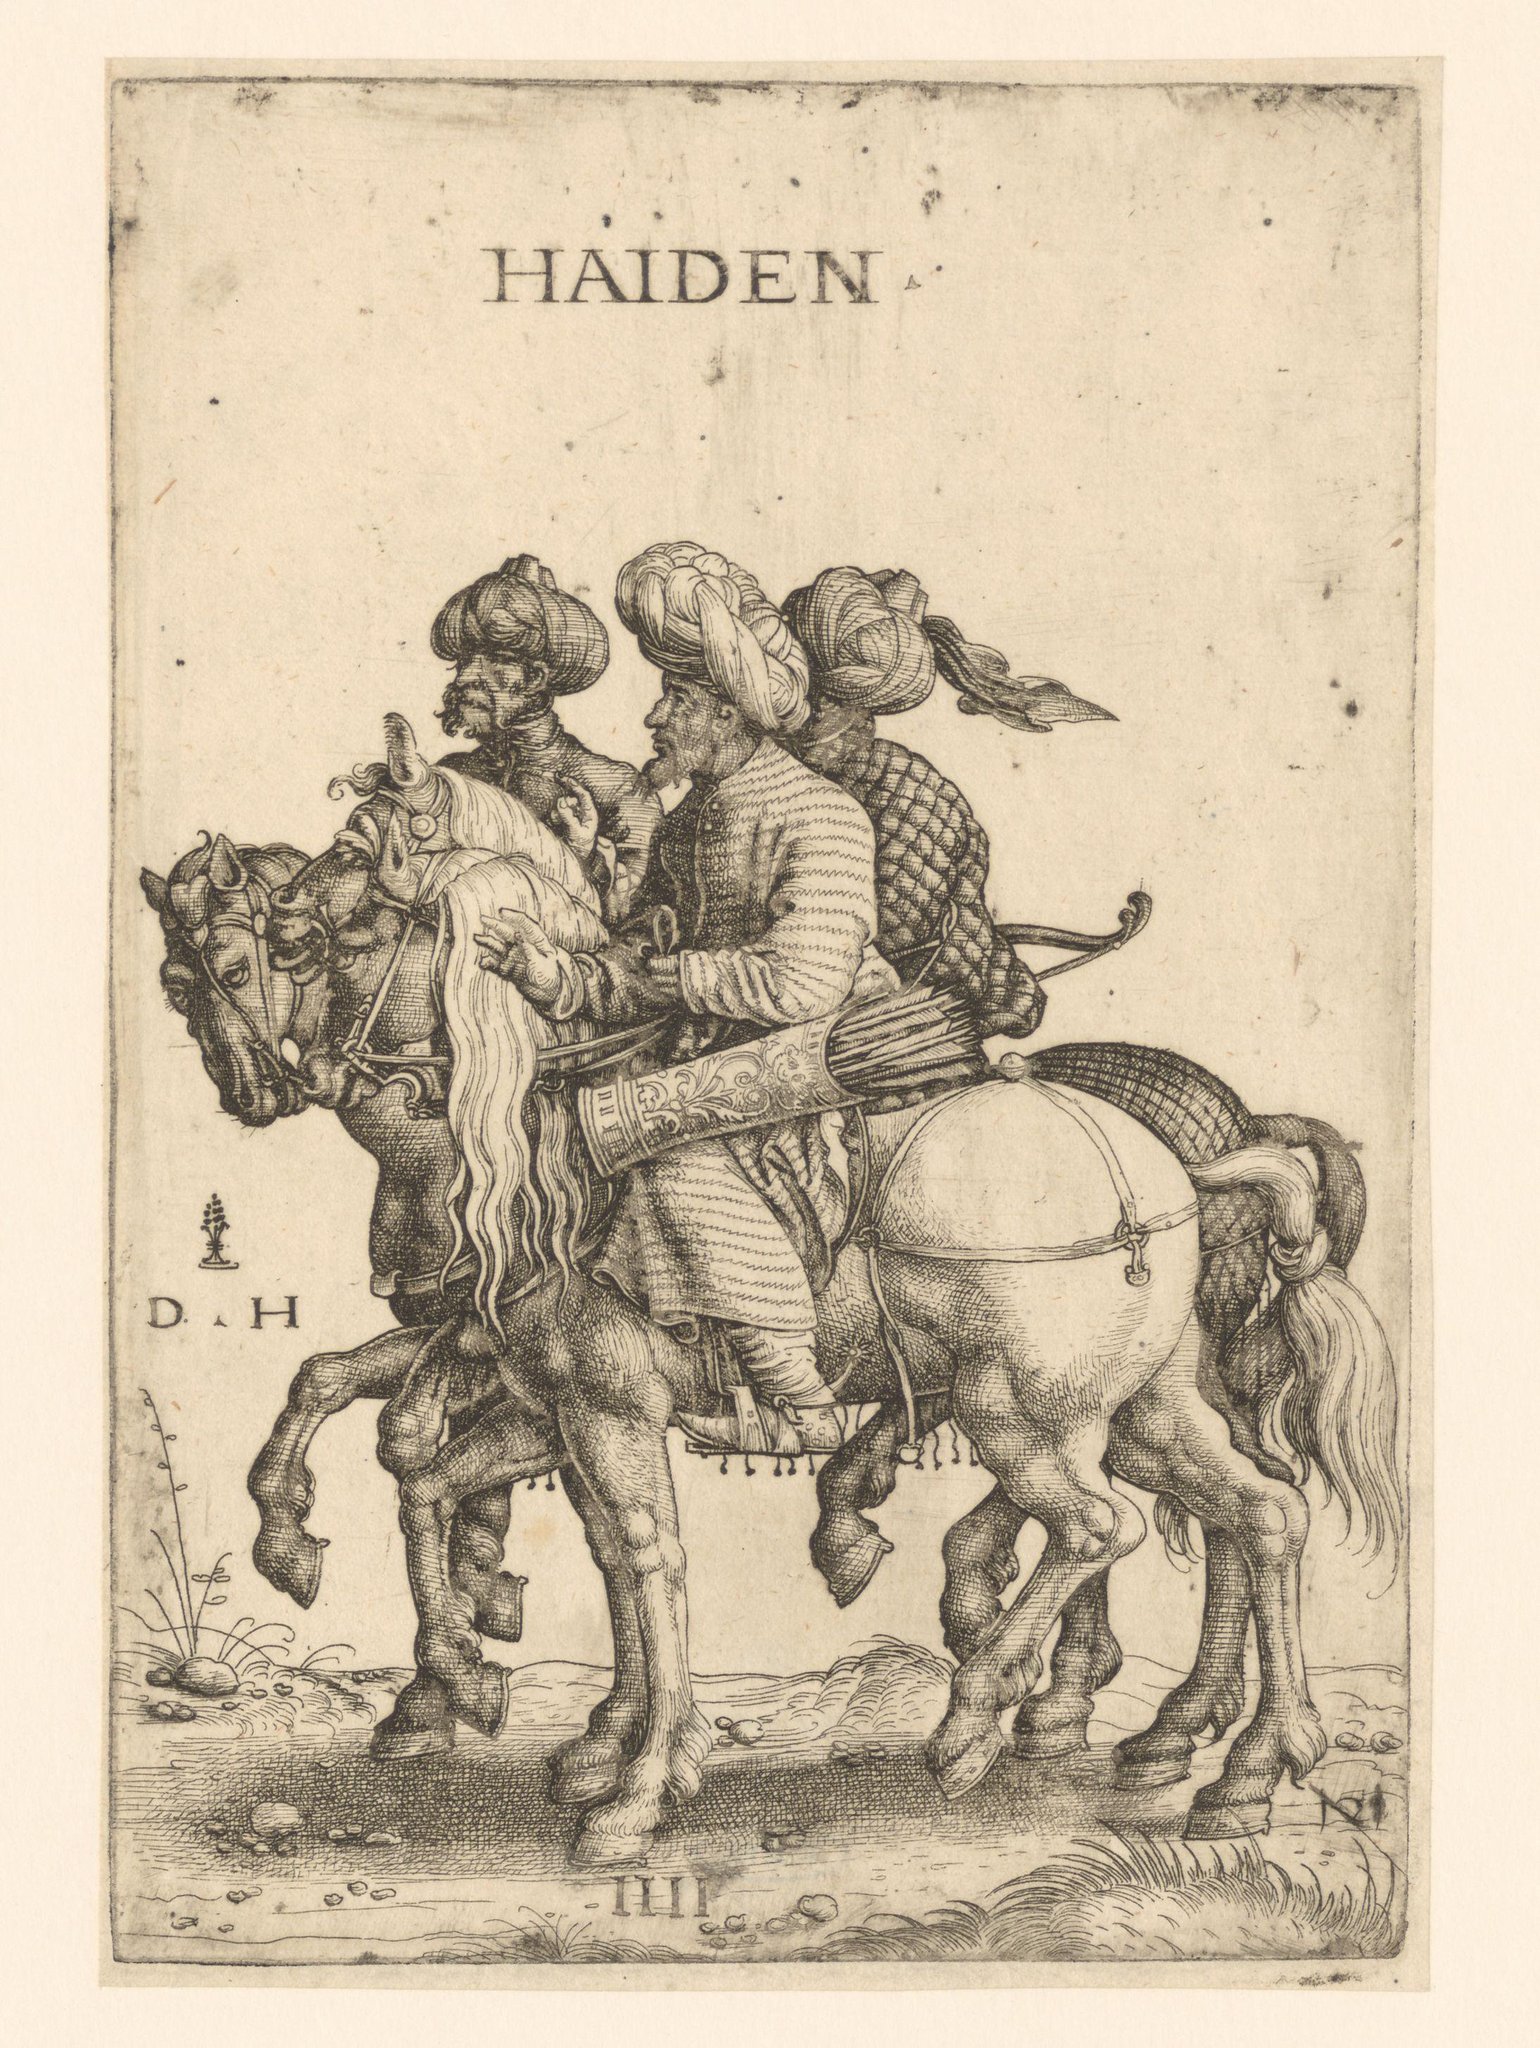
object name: print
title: Haiden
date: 1530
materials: paper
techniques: etching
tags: triumphal entry and public reception, pageant, 'entrée solennelle', 'joyeuse entrée', military parade, pageant, (military) uniforms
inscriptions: collector's mark: Lugt 2228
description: Deze prent is onderdeel van een serie naar Jan Swart's ontwerp uit 1526 met vijf prenten van Kanu Sultan Süleyman en zijn cortège, getiteld 'Soleiman de Grote en Turkse ruiters'. David Funck (1642-1709) kocht 230 ijzeren platen van de prentenmakers uit de familie Hopfer aan, nummerde deze (nu bekend als het Funck nummer) en herdrukte de verder onaangetaste platen onder de titel Operae Hopferianae in 1684 in Neurenberg. (Metzger, 2009)